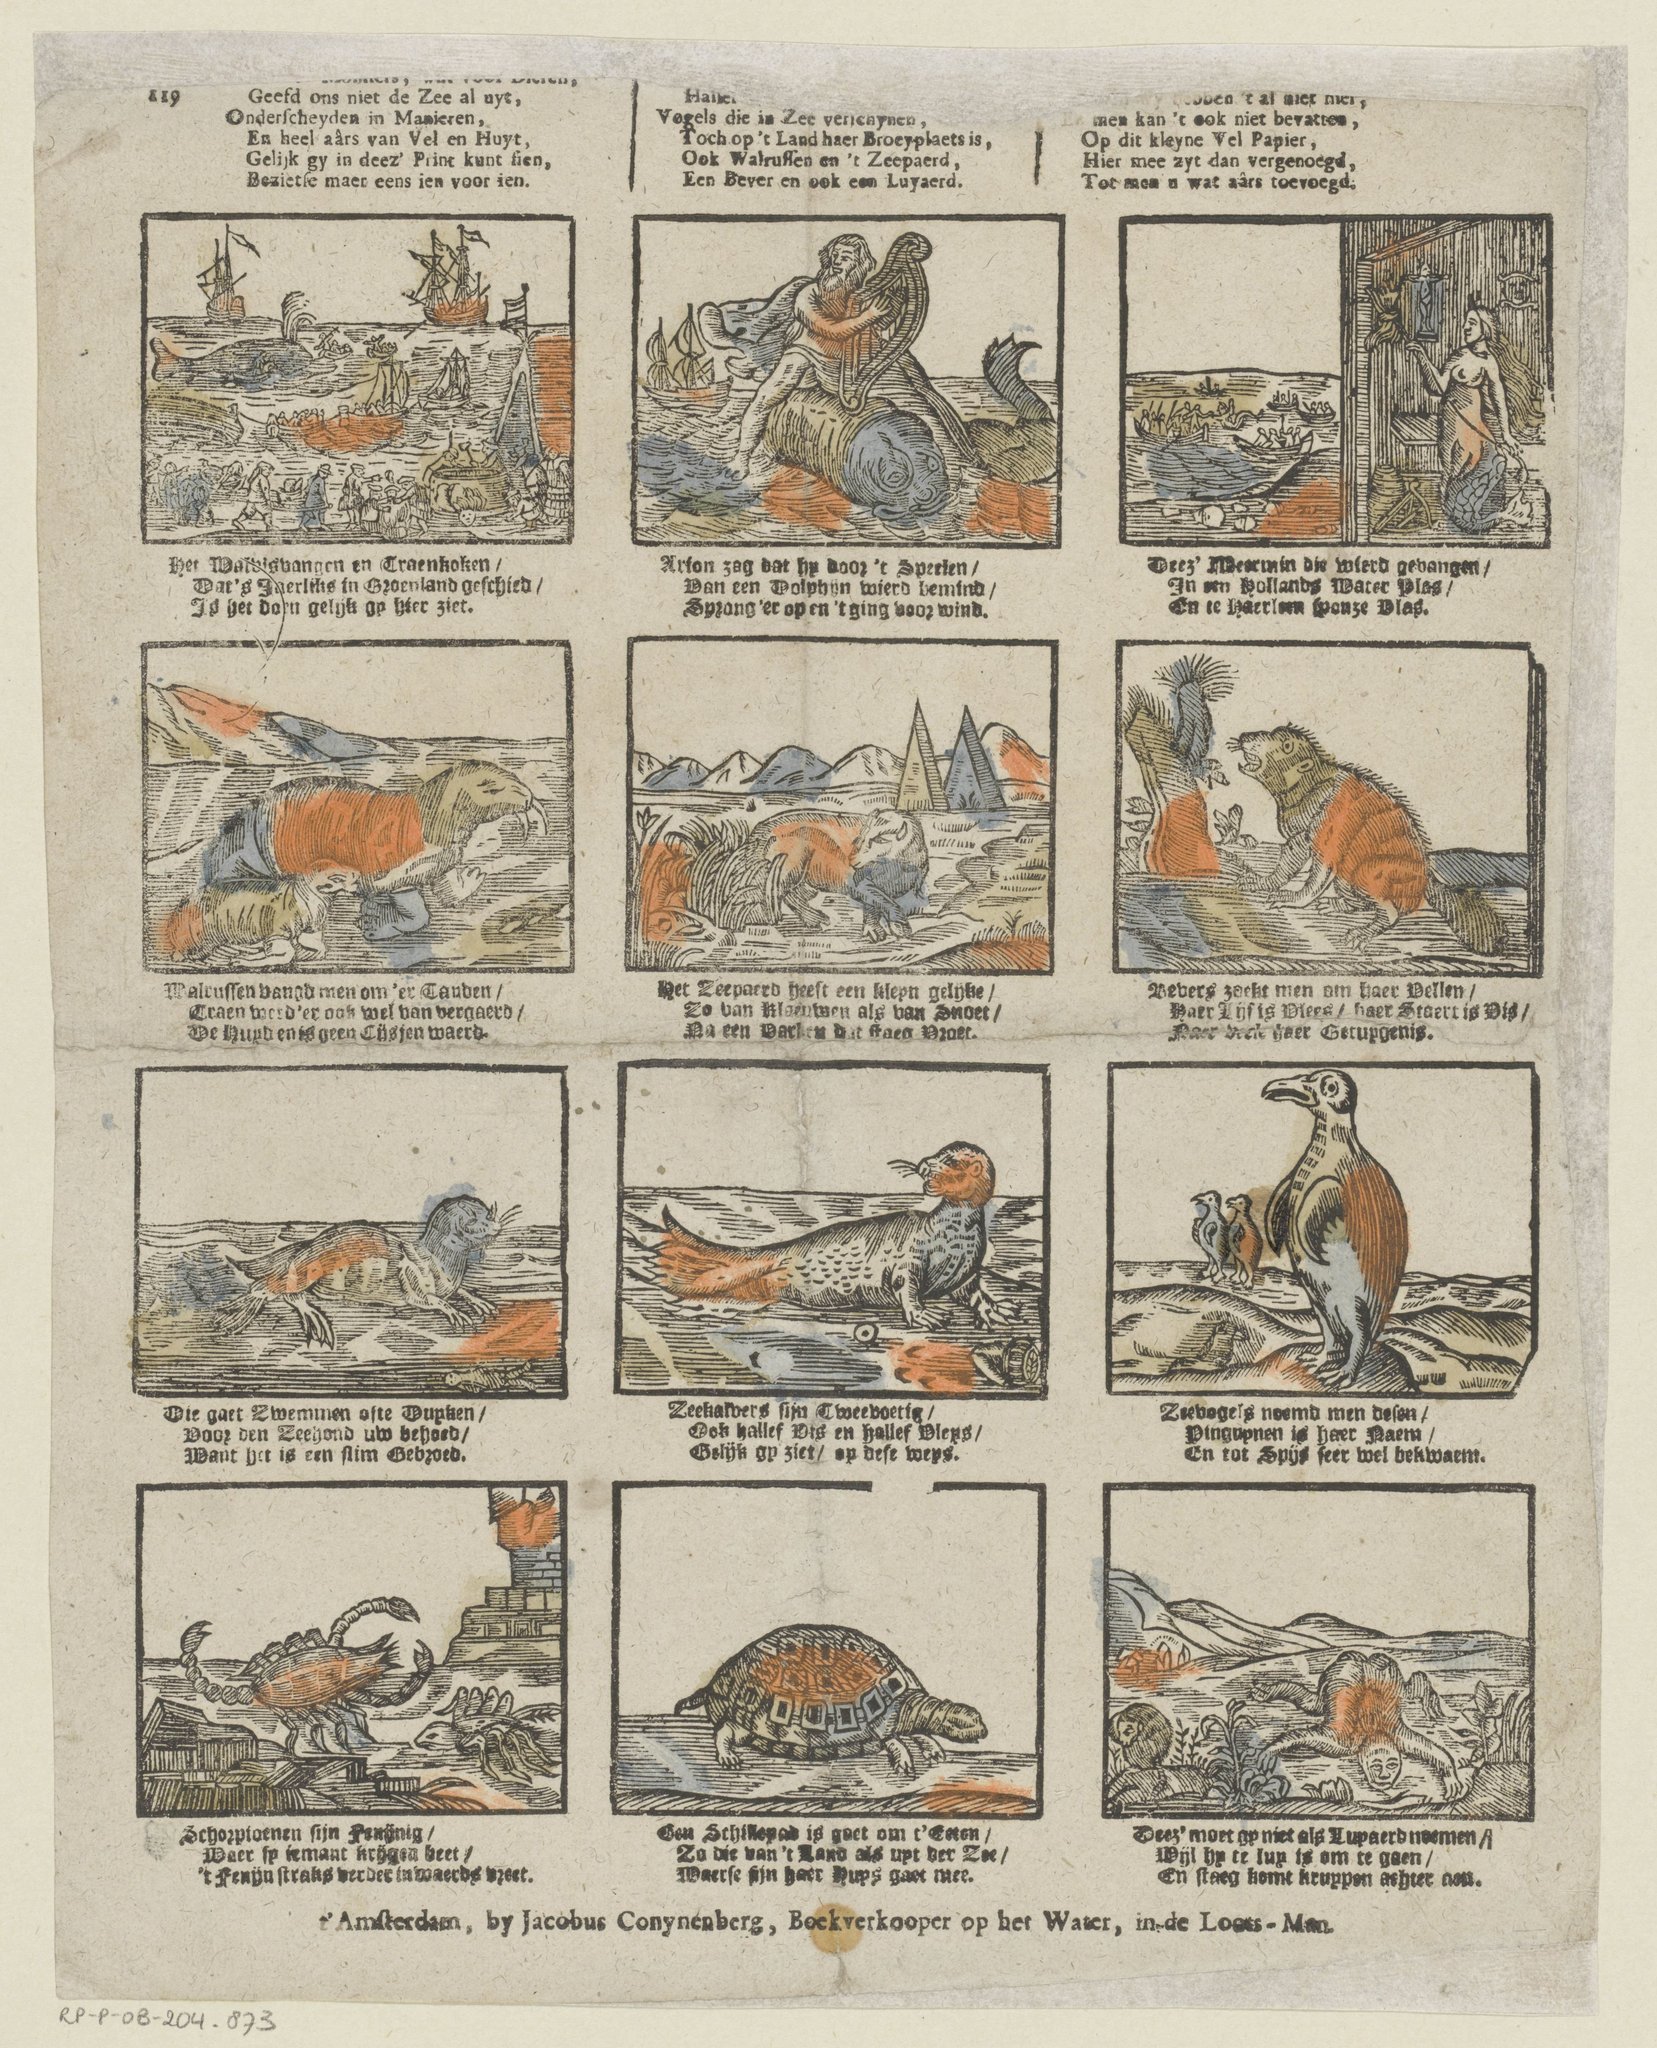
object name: popular print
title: [Wat voor monsters / wat voor dieren/) Geefd on niet de zee al uyt [(...)]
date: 1711-1723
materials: paper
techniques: colour, letterpress printing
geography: netherlands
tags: animals, merman - aa - mermaid, siren, scorpions, whale fishery, whaling, swimming mammals: seal, swimming mammals: walrus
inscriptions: collector's mark: Lugt 2760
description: Blad met 12 voorstellingen van de walvisvangst en van verschillende dieren. Onder elke afbeelding een drieregelig onderschrift. Genummerd linksboven: 119.